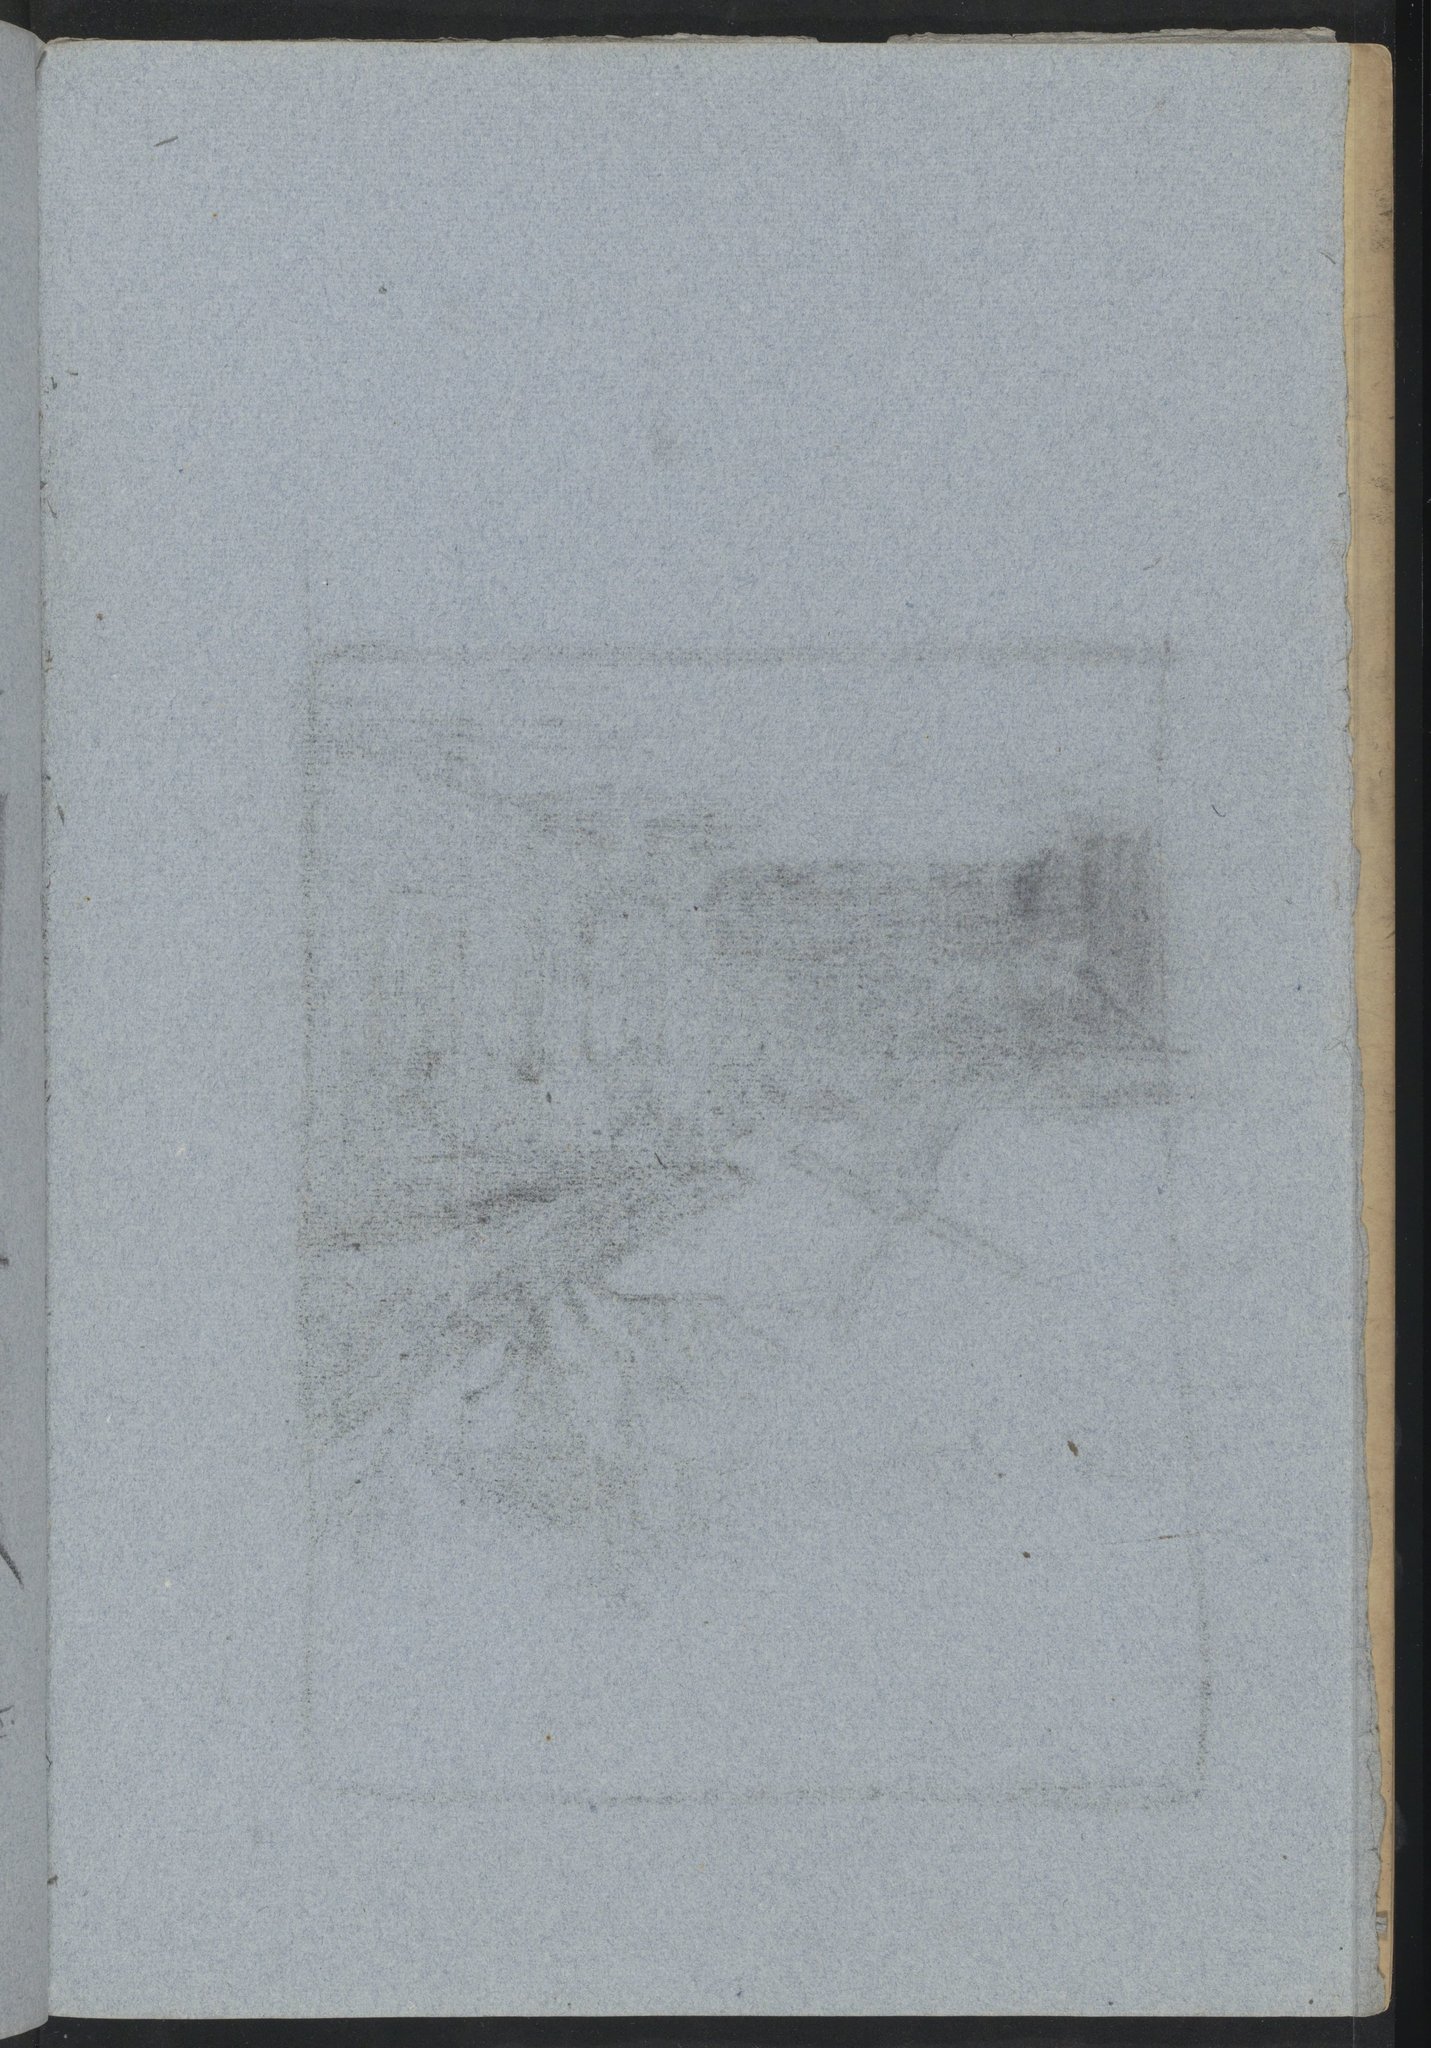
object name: sketchbook leaf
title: Abklatsch van de krijttekening op pagina 31 verso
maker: jan veth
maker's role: designer, draughtsman, painter, print maker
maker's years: 1864-1925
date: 1874-1925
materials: paper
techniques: printmaking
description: Blad 32 recto uit een schetsboek met 42 bladen.